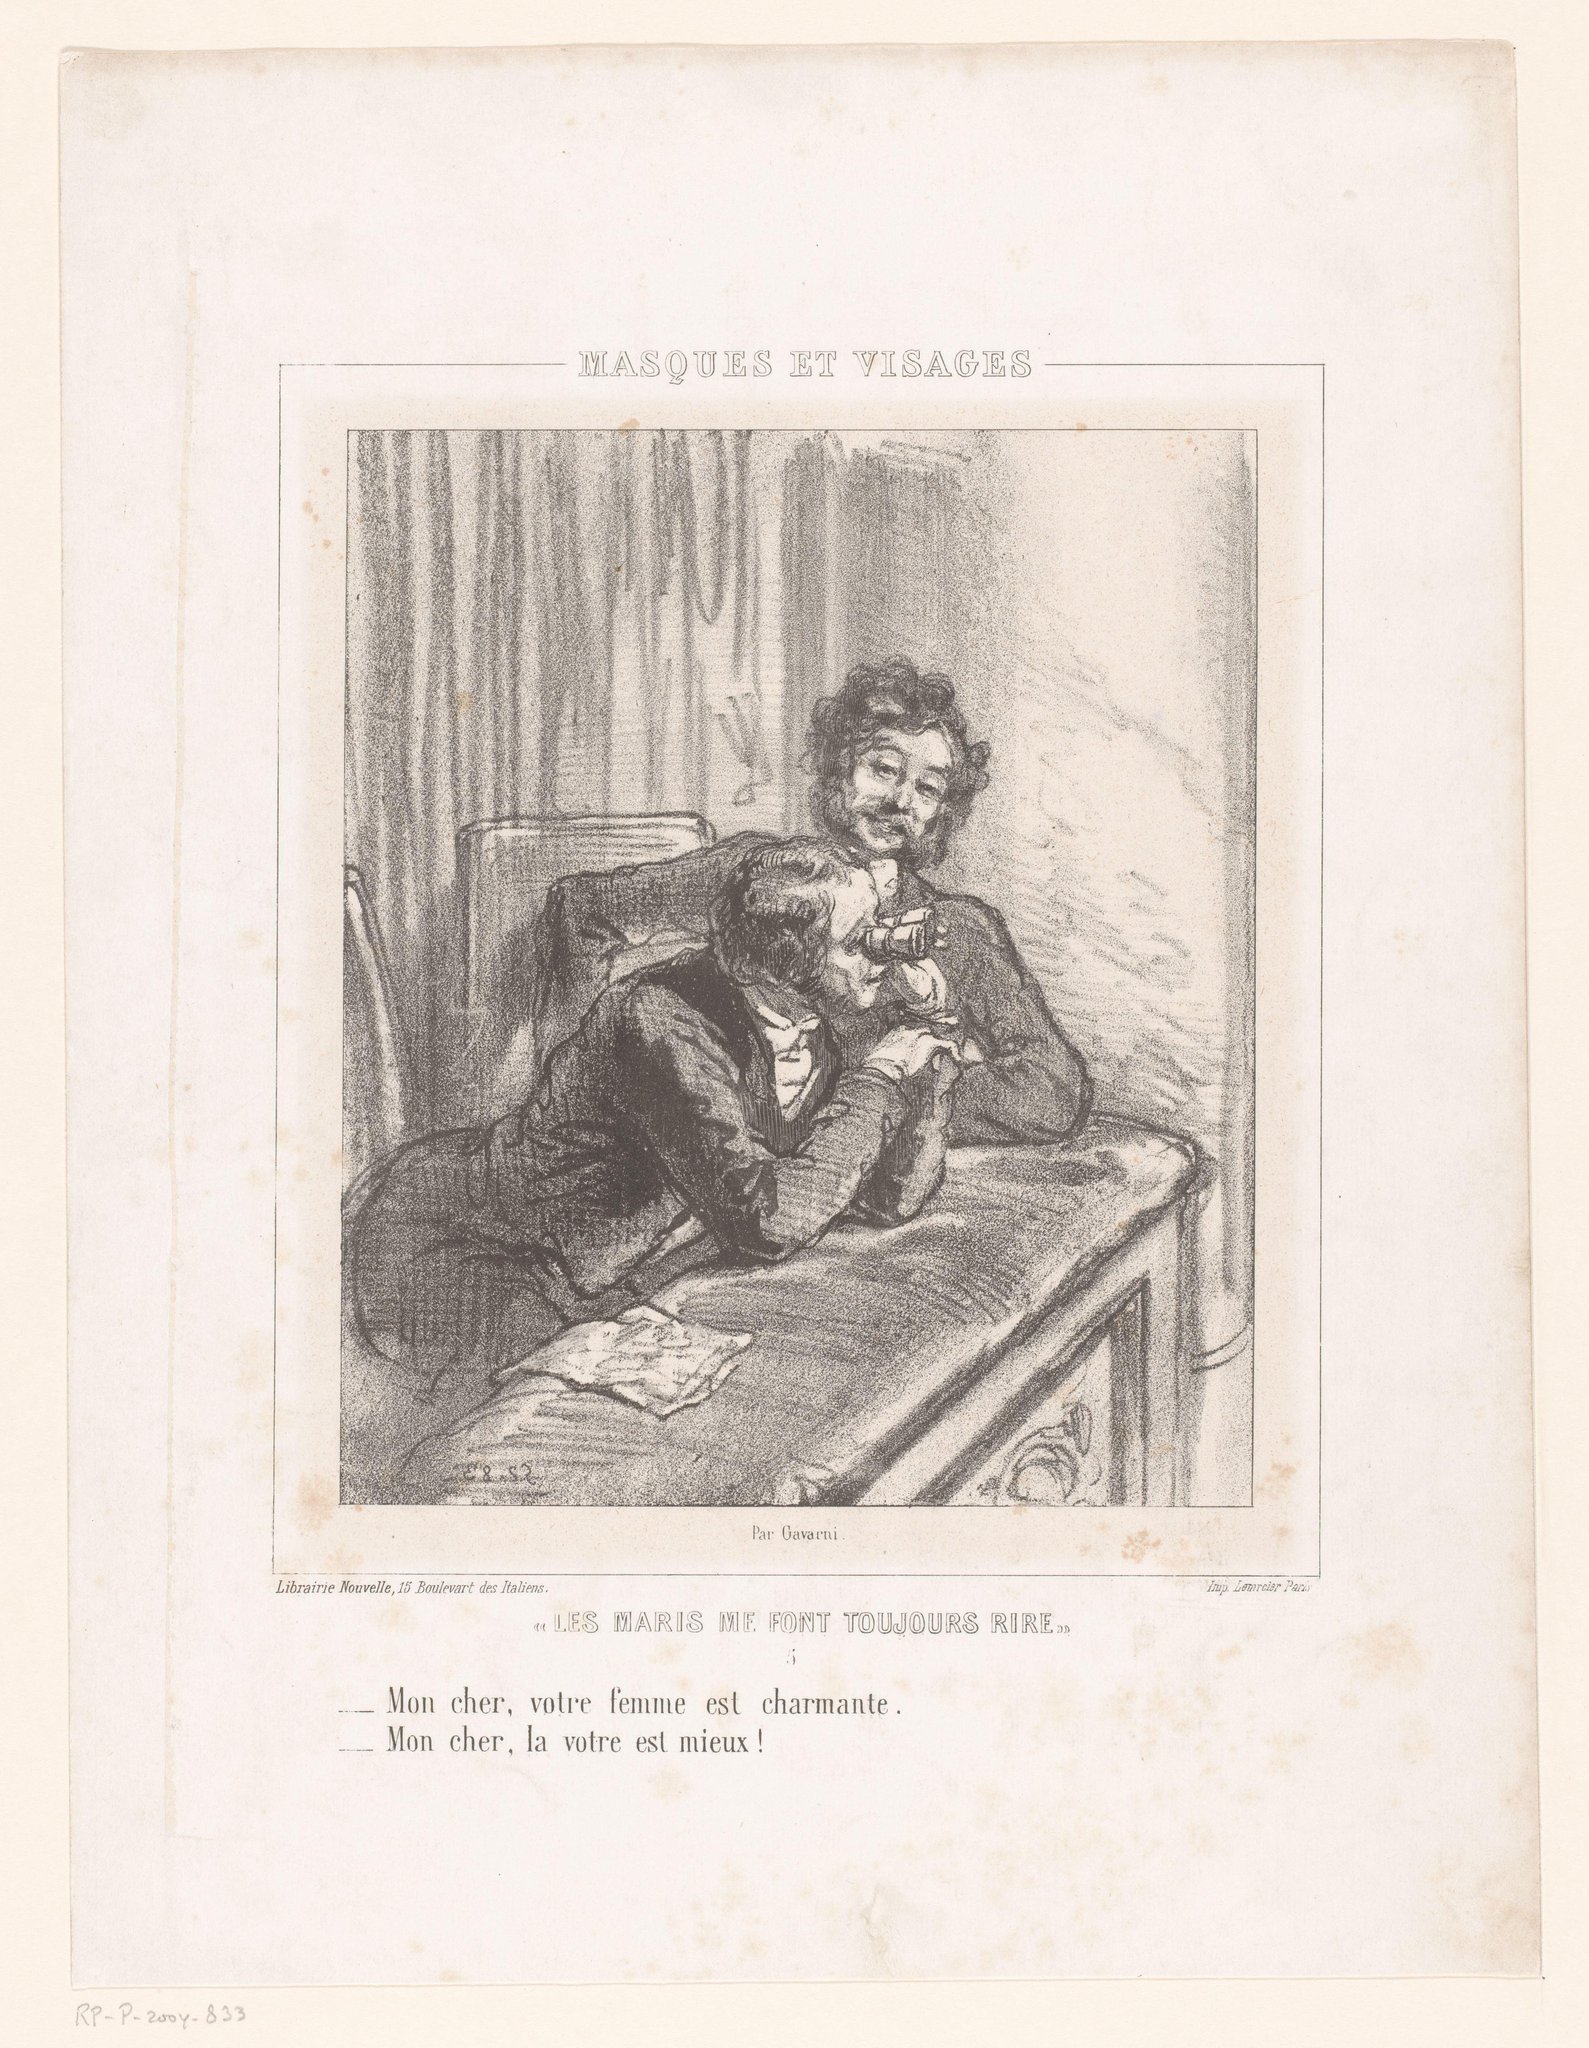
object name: print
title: Masques et visages. Les maris me font toujours rire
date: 1853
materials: paper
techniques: lithograph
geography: paris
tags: boxes, loges ~ theatre, etc., binoculars, spy-glass, etc.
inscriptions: collector's mark: Lugt 2228a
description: Prent gebruikt voor: Paris (journal), 9 januari 1853.